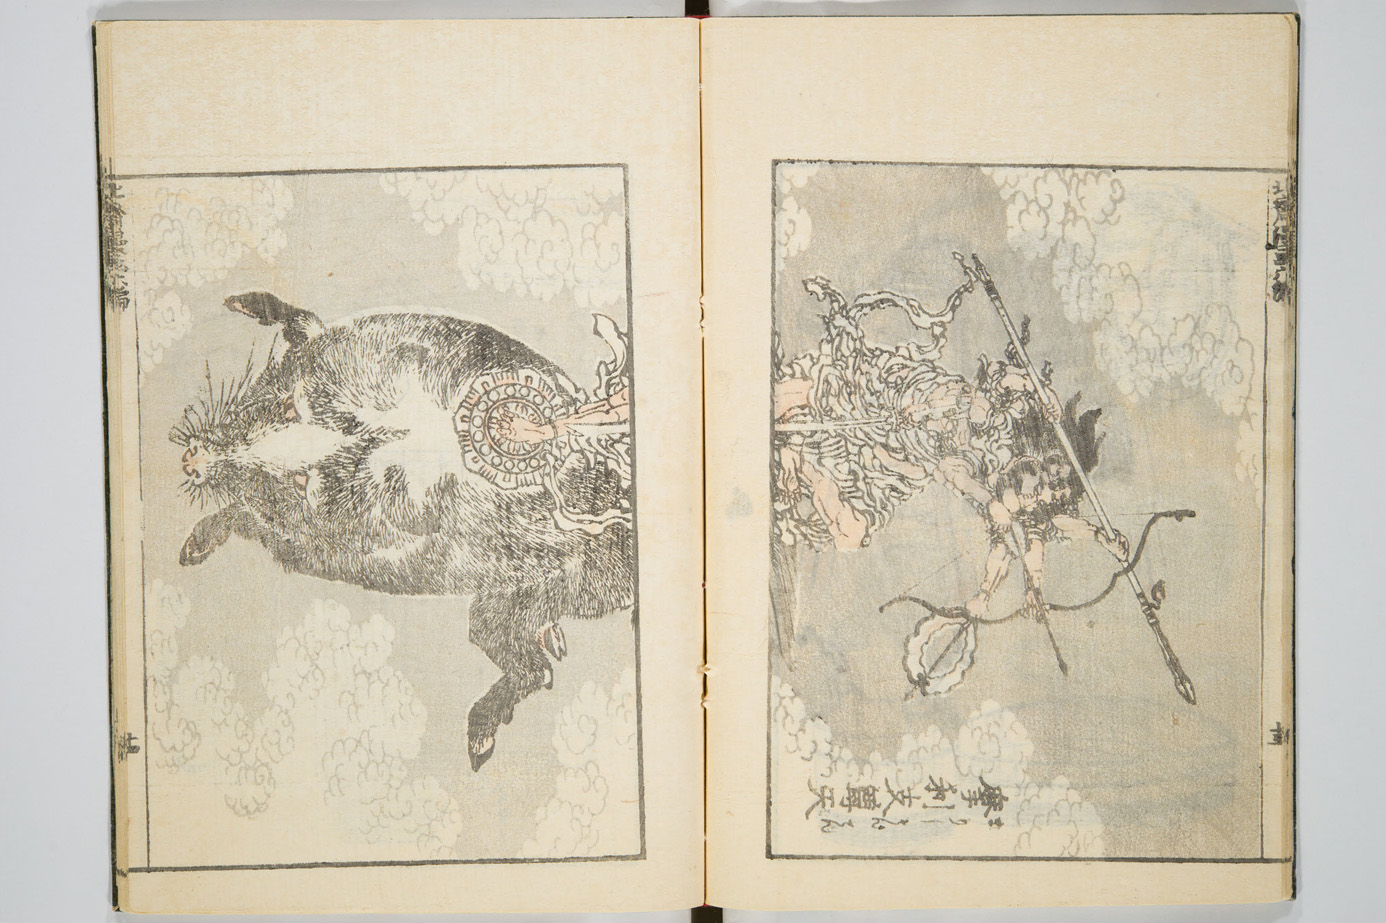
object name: illustrated book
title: Transmitting the Spirit, Revealing the Form of Things, Volume 6 of Hokusai Sketchbooks (Denshin kaishu: Hokusai manga, gohen)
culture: japanese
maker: katsushika hokusai 葛飾北斎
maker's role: artist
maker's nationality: japanese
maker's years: 1760-1849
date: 1801-1900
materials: ink, paper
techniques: woodblock print